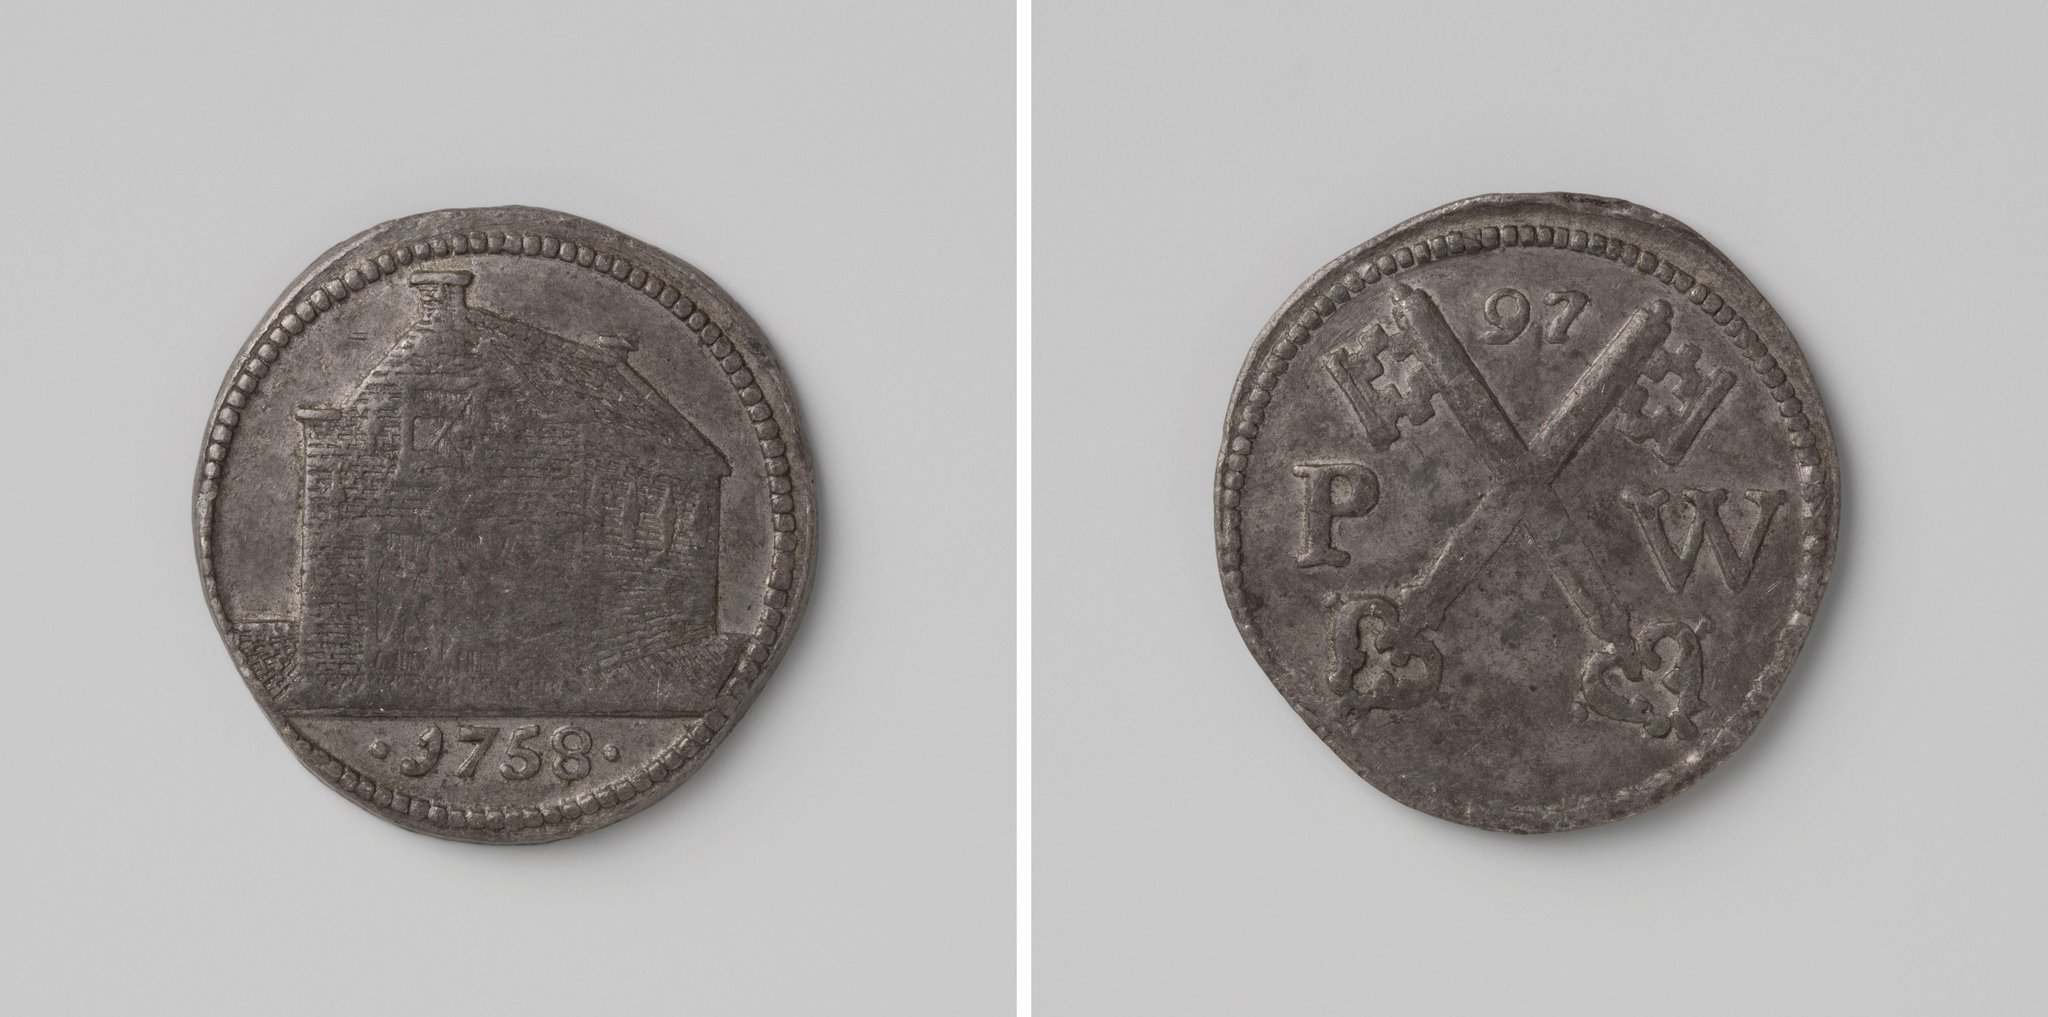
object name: armenloodje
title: Waalse gemeente van Leiden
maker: Anonymous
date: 1758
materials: lead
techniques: striking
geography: leiden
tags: leiden